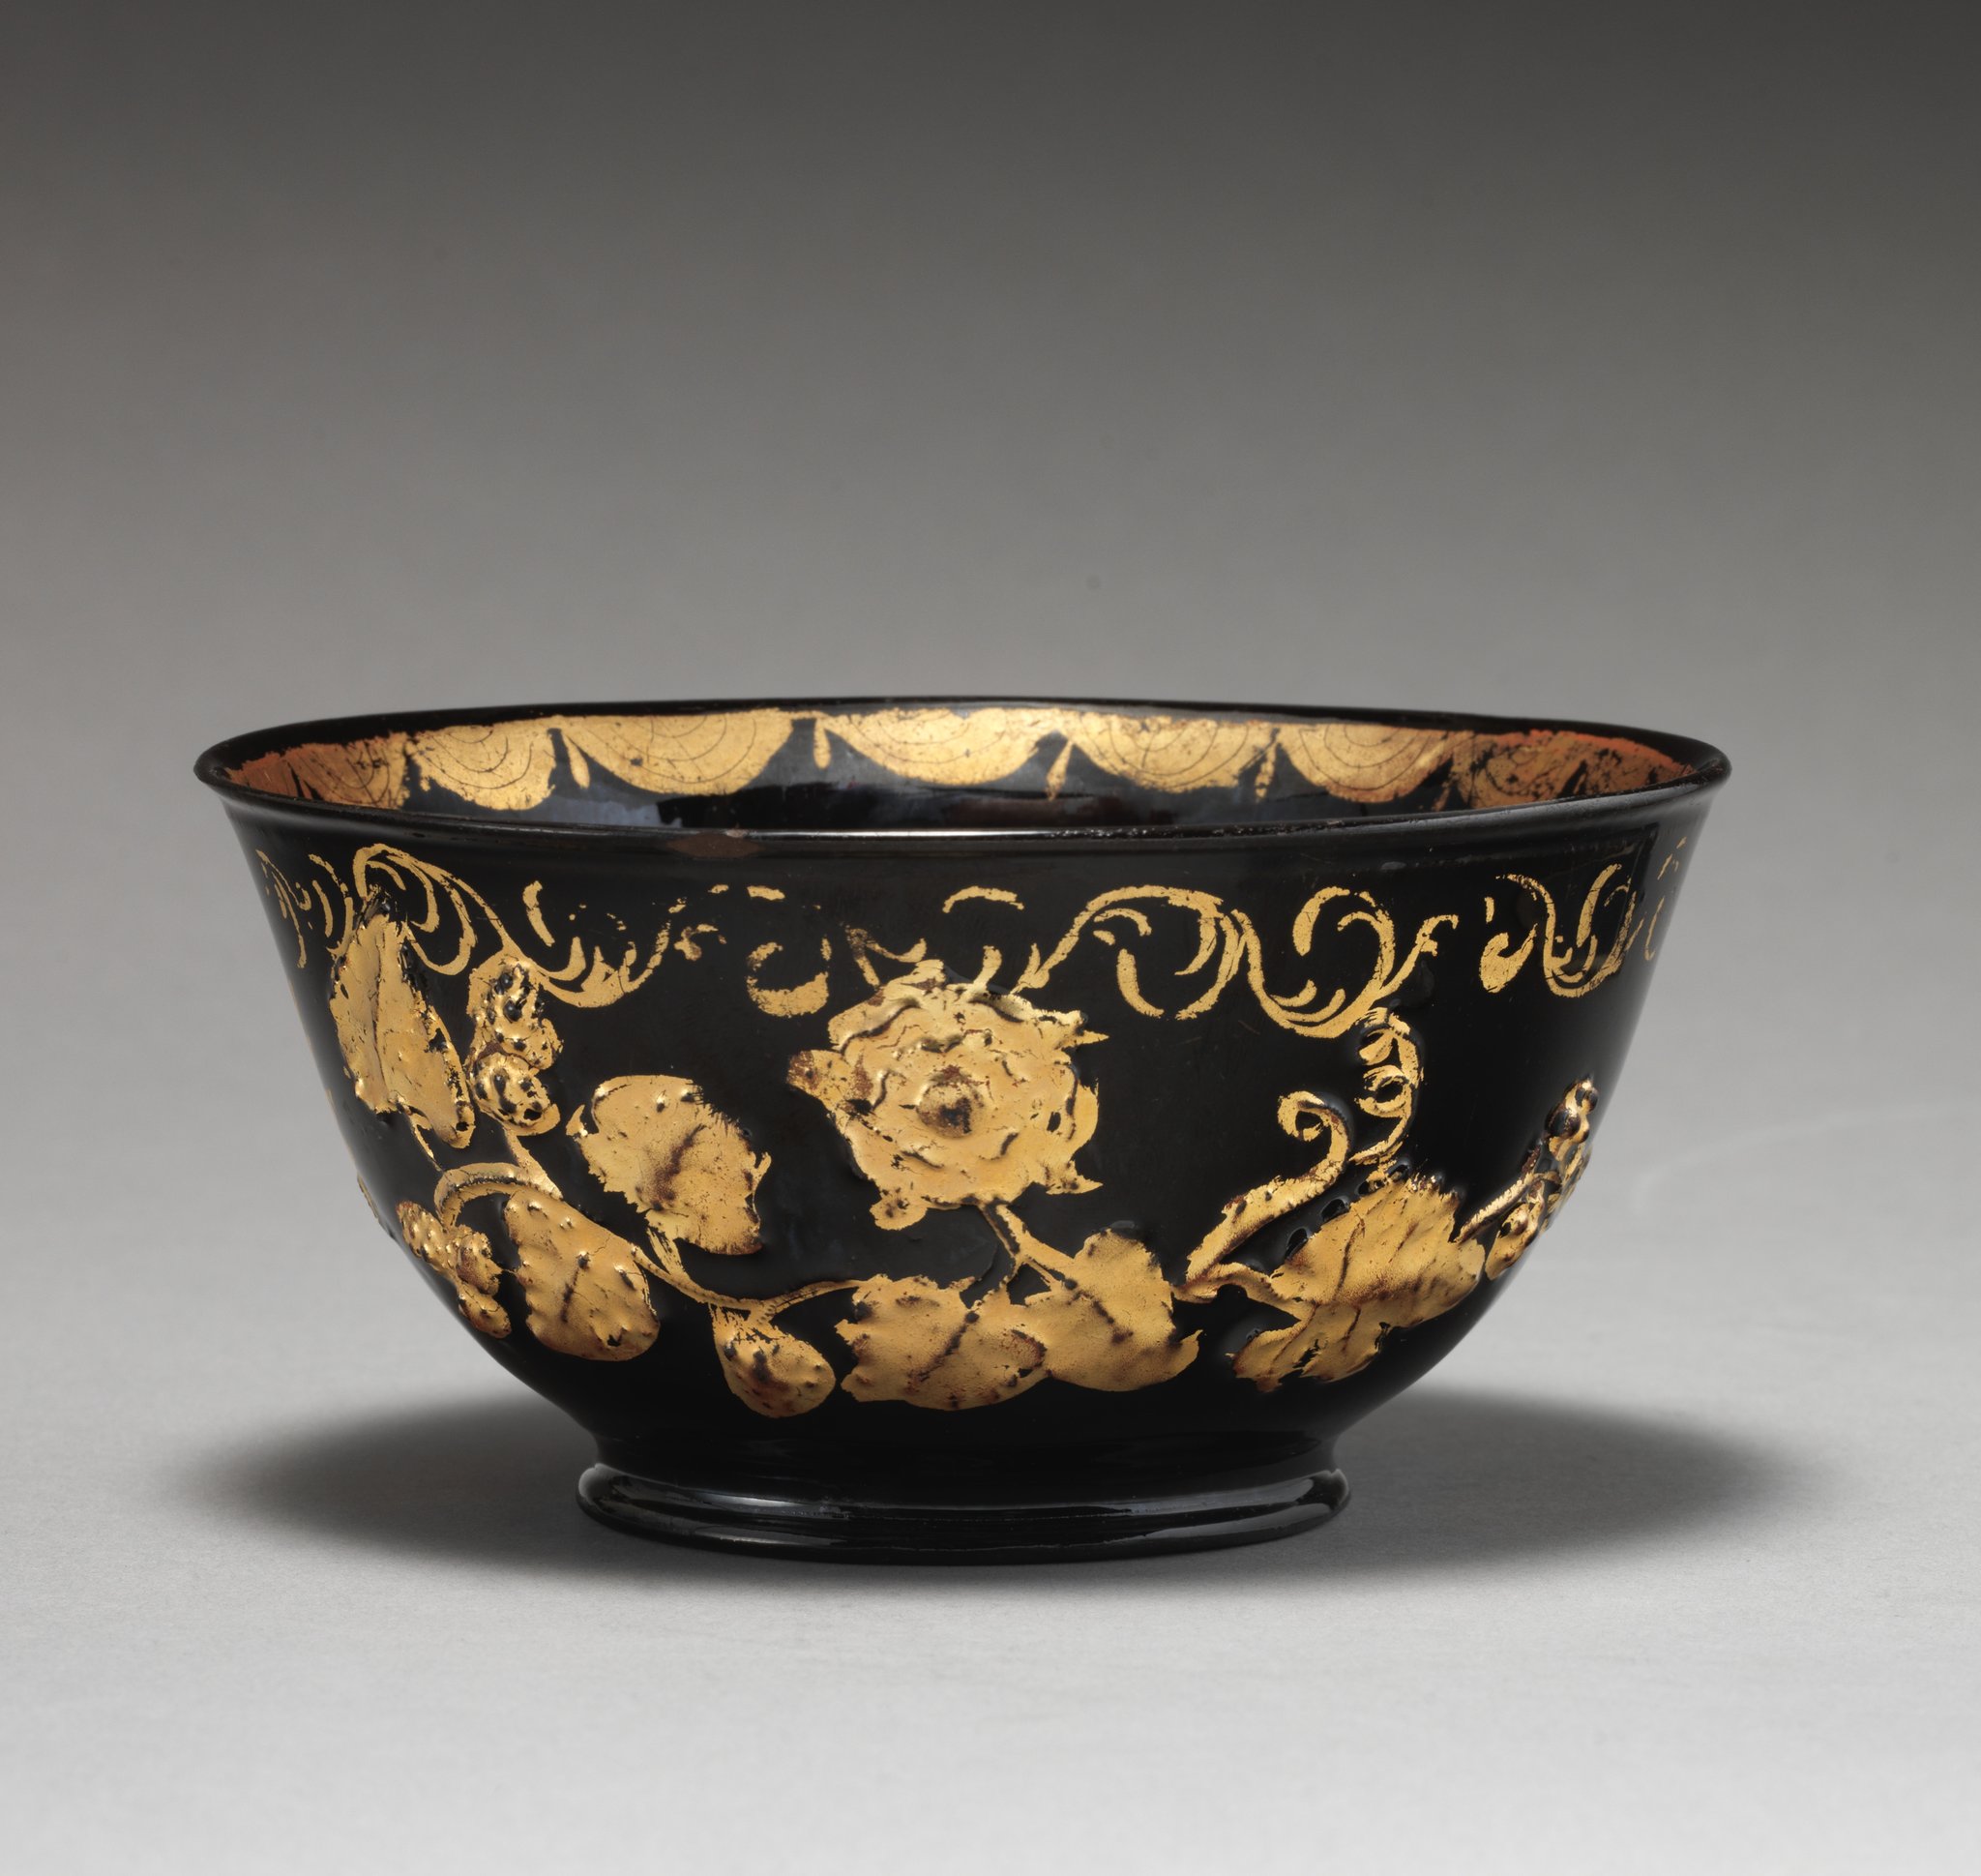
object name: bowl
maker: jackfield pottery, shropshire, england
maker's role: factory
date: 1760-1775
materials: earthenware